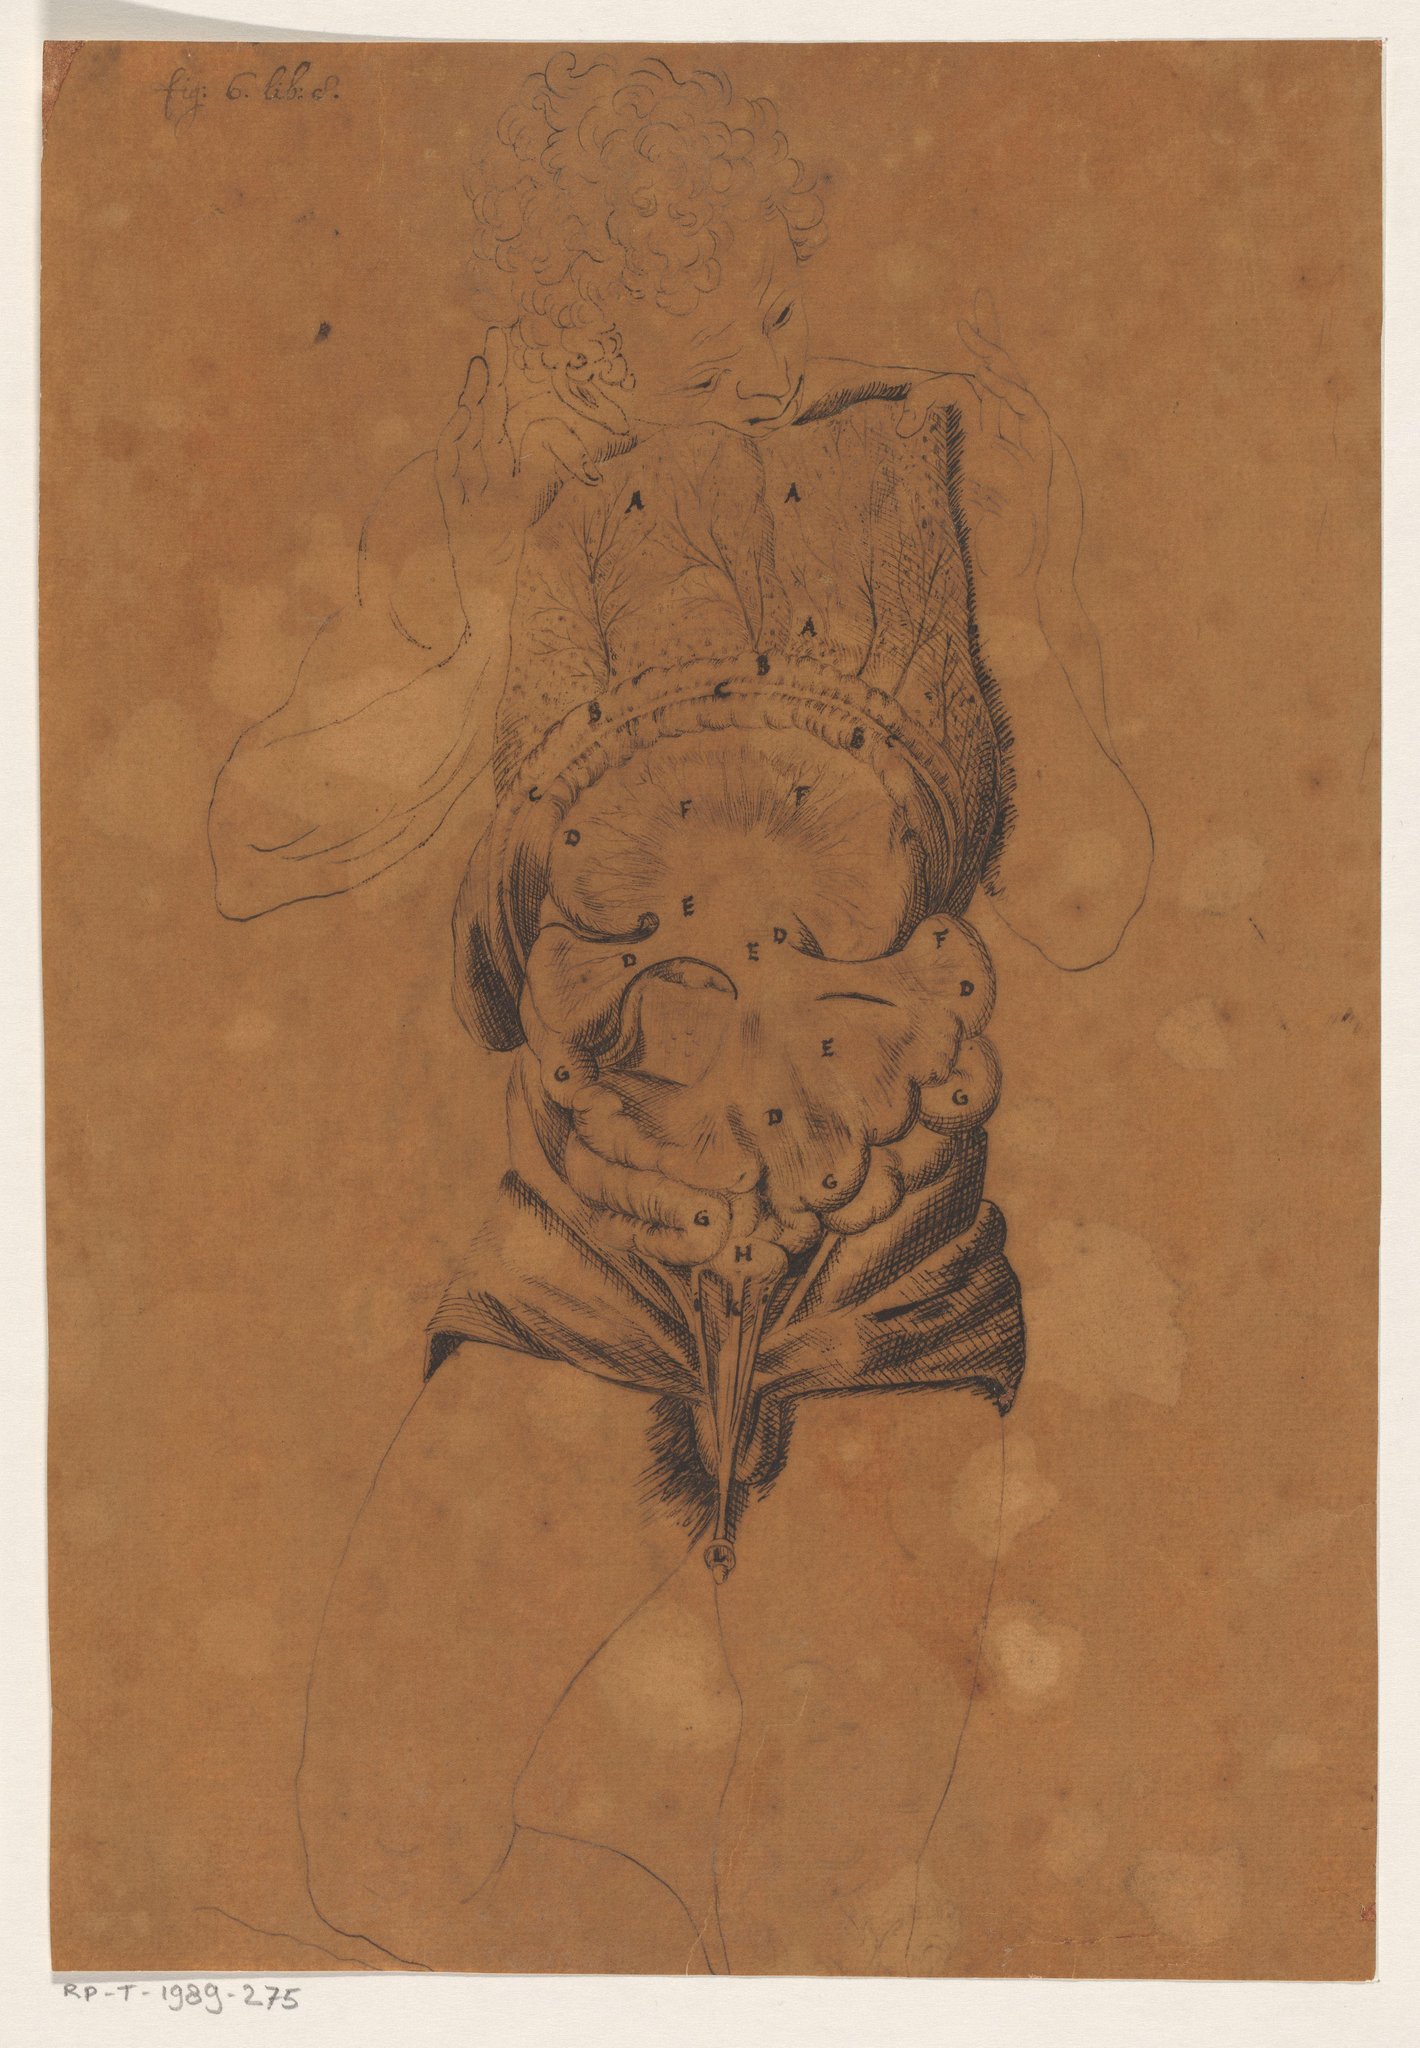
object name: drawing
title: Ingewanden van een man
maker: Anonymous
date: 1630-1649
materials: ink, paper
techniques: pen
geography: low countries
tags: intestines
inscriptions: collector's mark: Lugt 2228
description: De tekening en de letters die de verschillende onderdelen aanduiden komen overeen met een prent uit: Spiegel, Adriaan van den, en Daniel Bucretius. De humani corporis fabrica libri decem. Venetië: s.n., 1627. Tekening zit in een omslag met meerdere anatomische tekeningen, genummerd RP-T-1989-256 en RP-T-1989-258 t/m RP-T-1989-289.